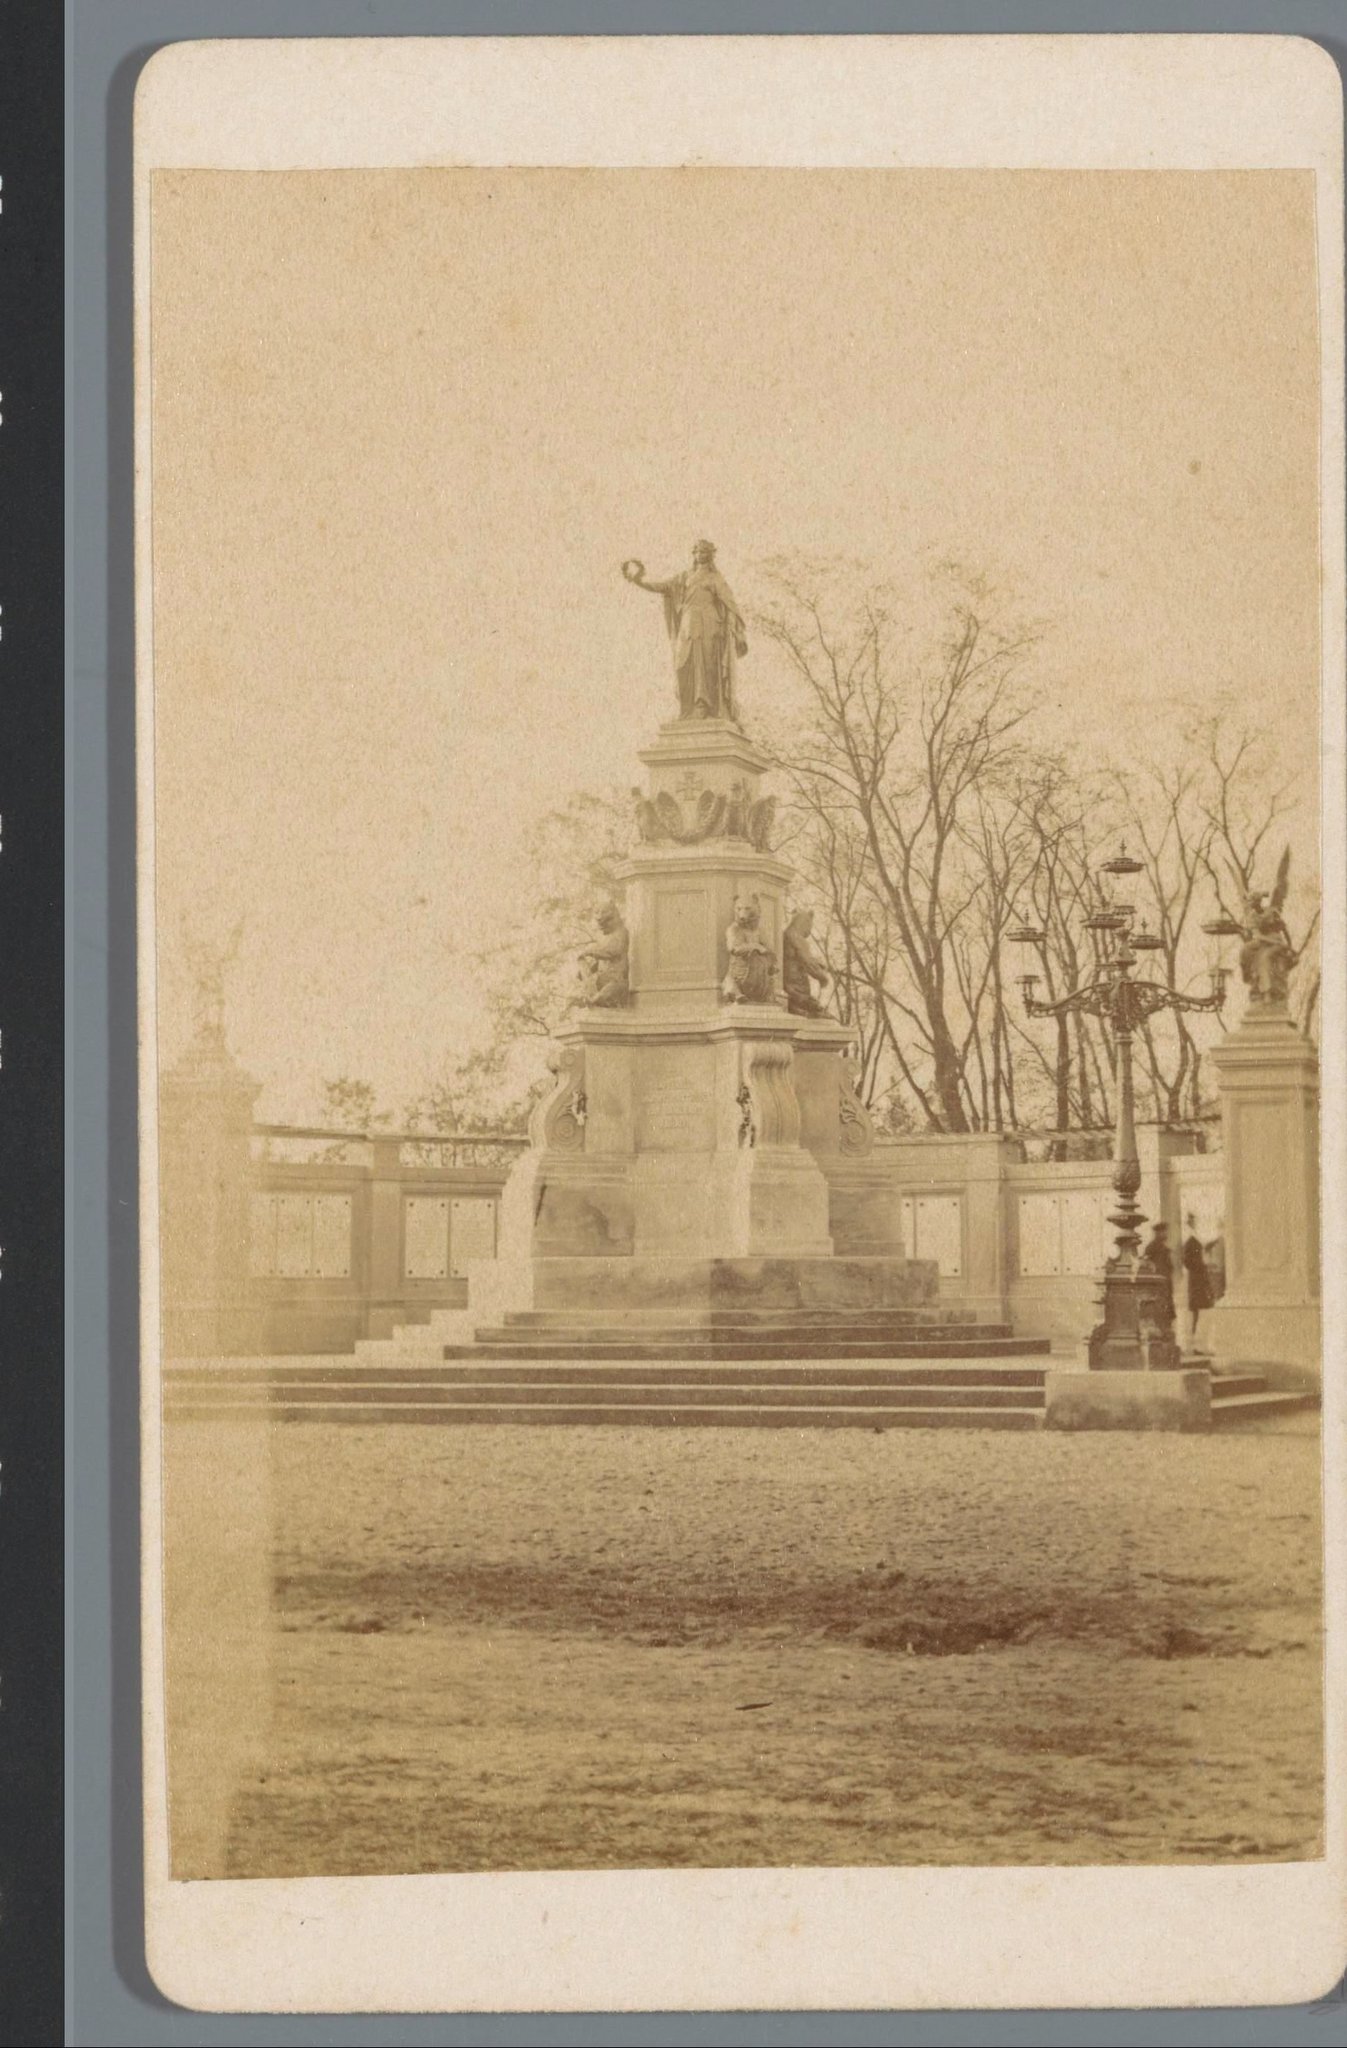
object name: photograph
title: Dessau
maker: Anonymous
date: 1860-1875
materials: cardboard, paper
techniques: albumen print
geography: dessau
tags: monument, statue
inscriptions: inscription: ‘5/’